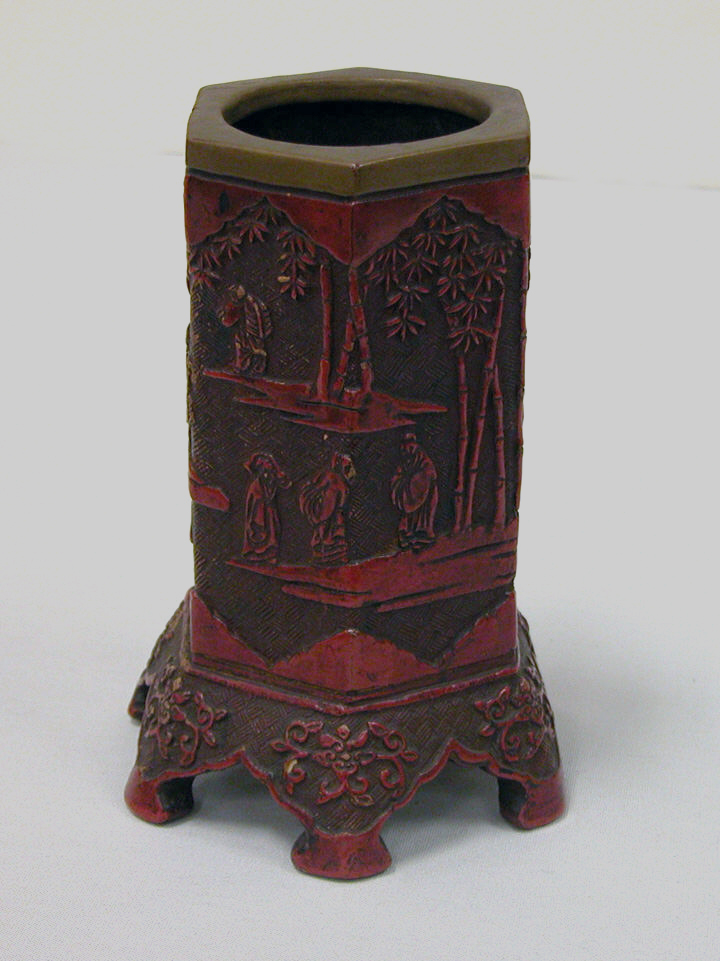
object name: brush holder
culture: japanese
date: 1834-1866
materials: lacquer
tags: human figures,bamboo